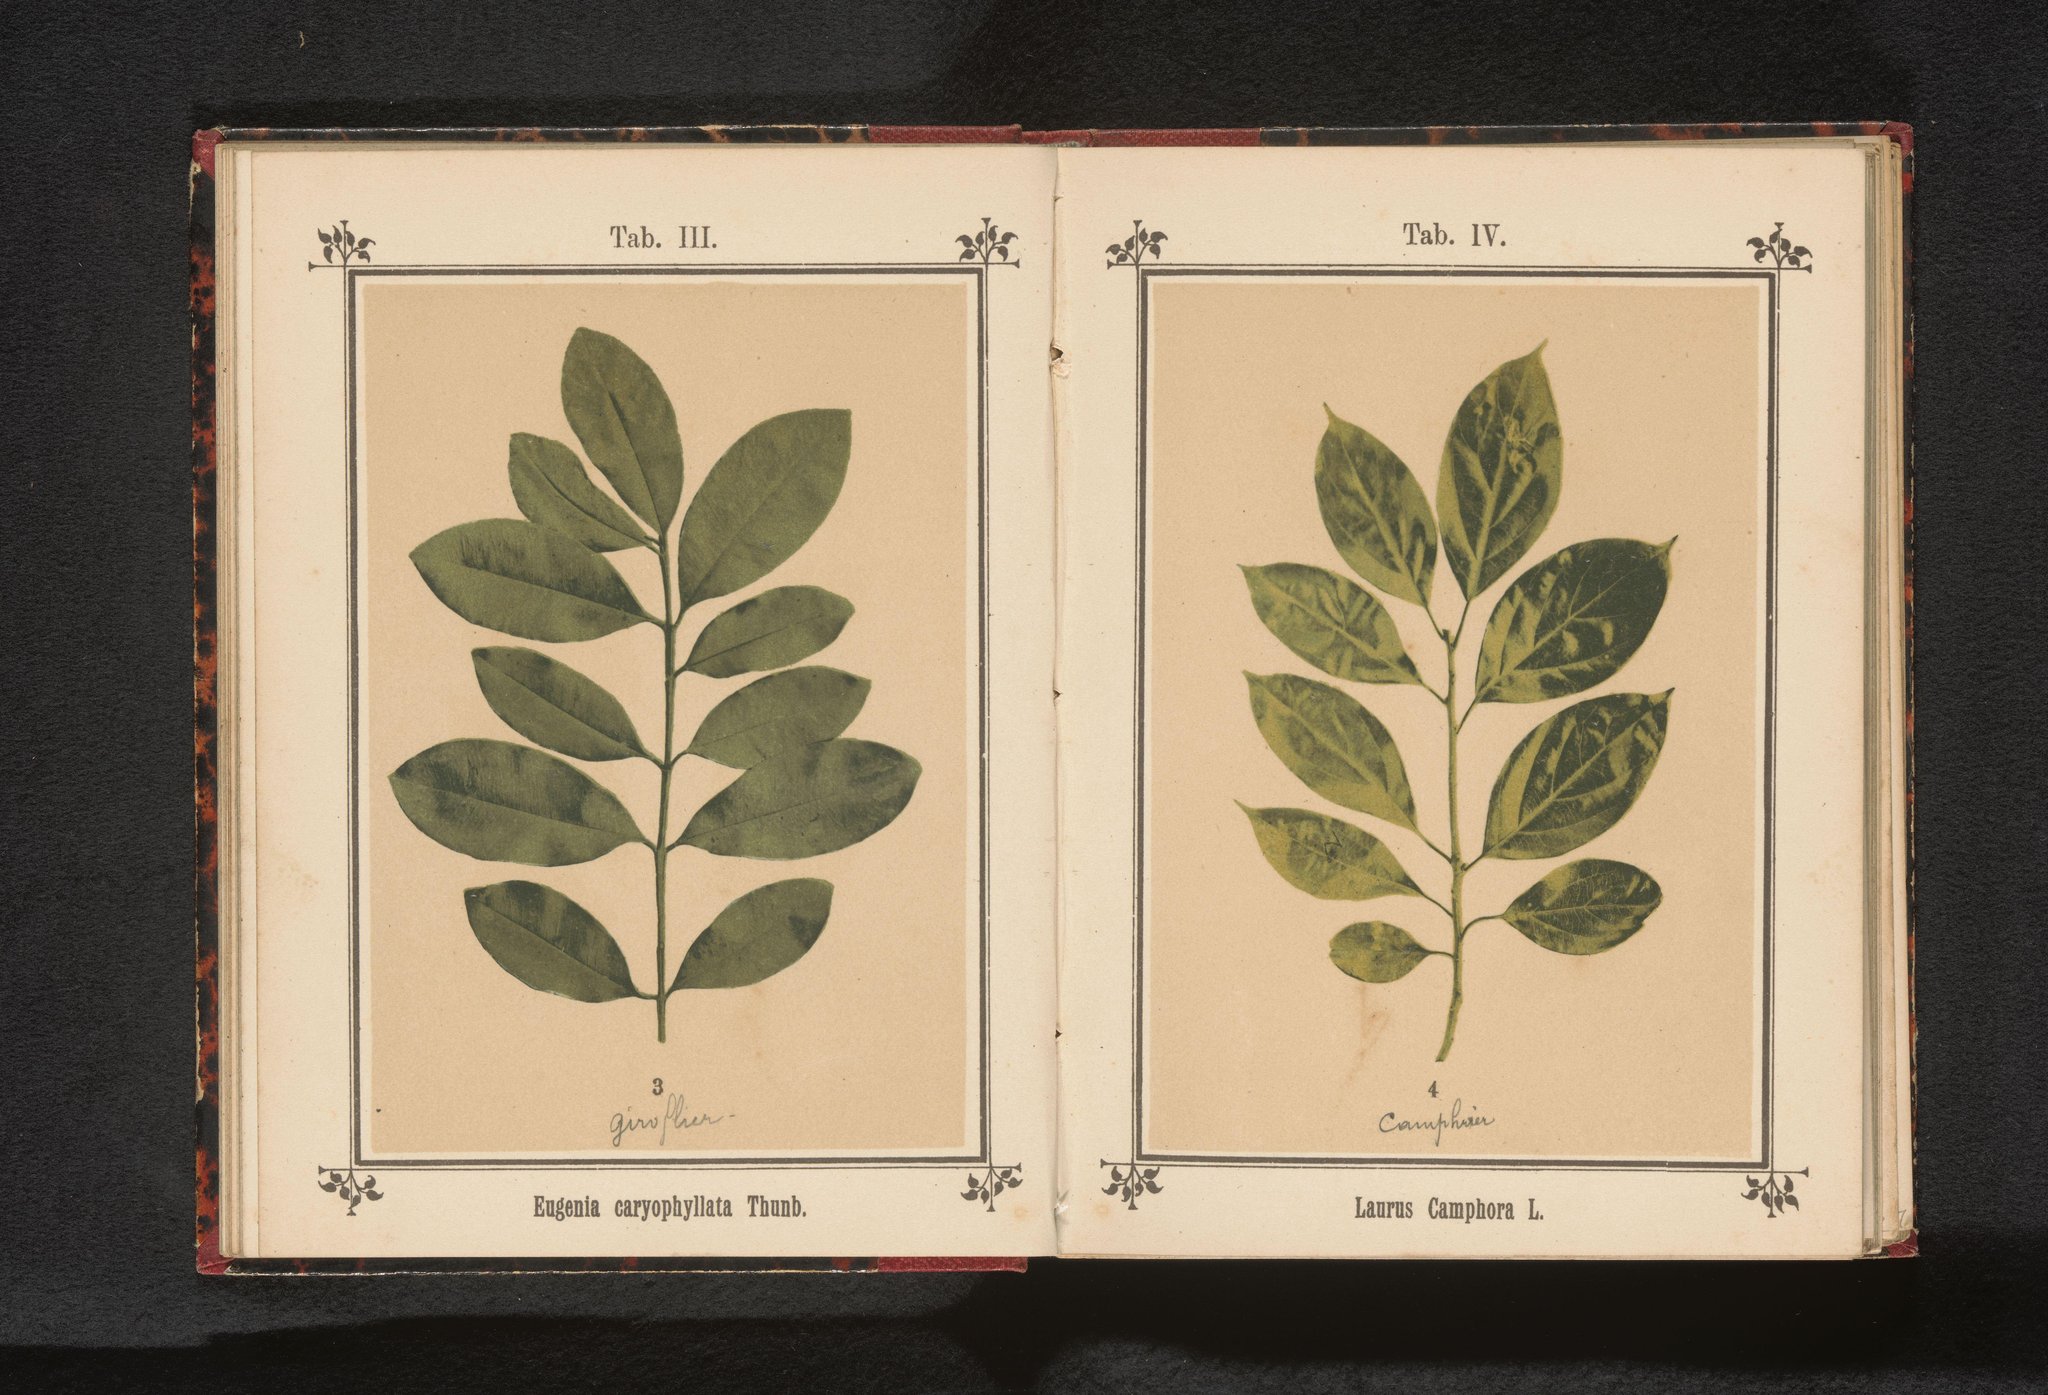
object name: photomechanical print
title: Eugenia caryophyllata Thunb.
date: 1884-1894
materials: paper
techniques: photograph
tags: trees (+ branch, stick), seasonings, spices (clove)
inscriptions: inscription: ‘giroflier’, number: ‘Tab. III.’